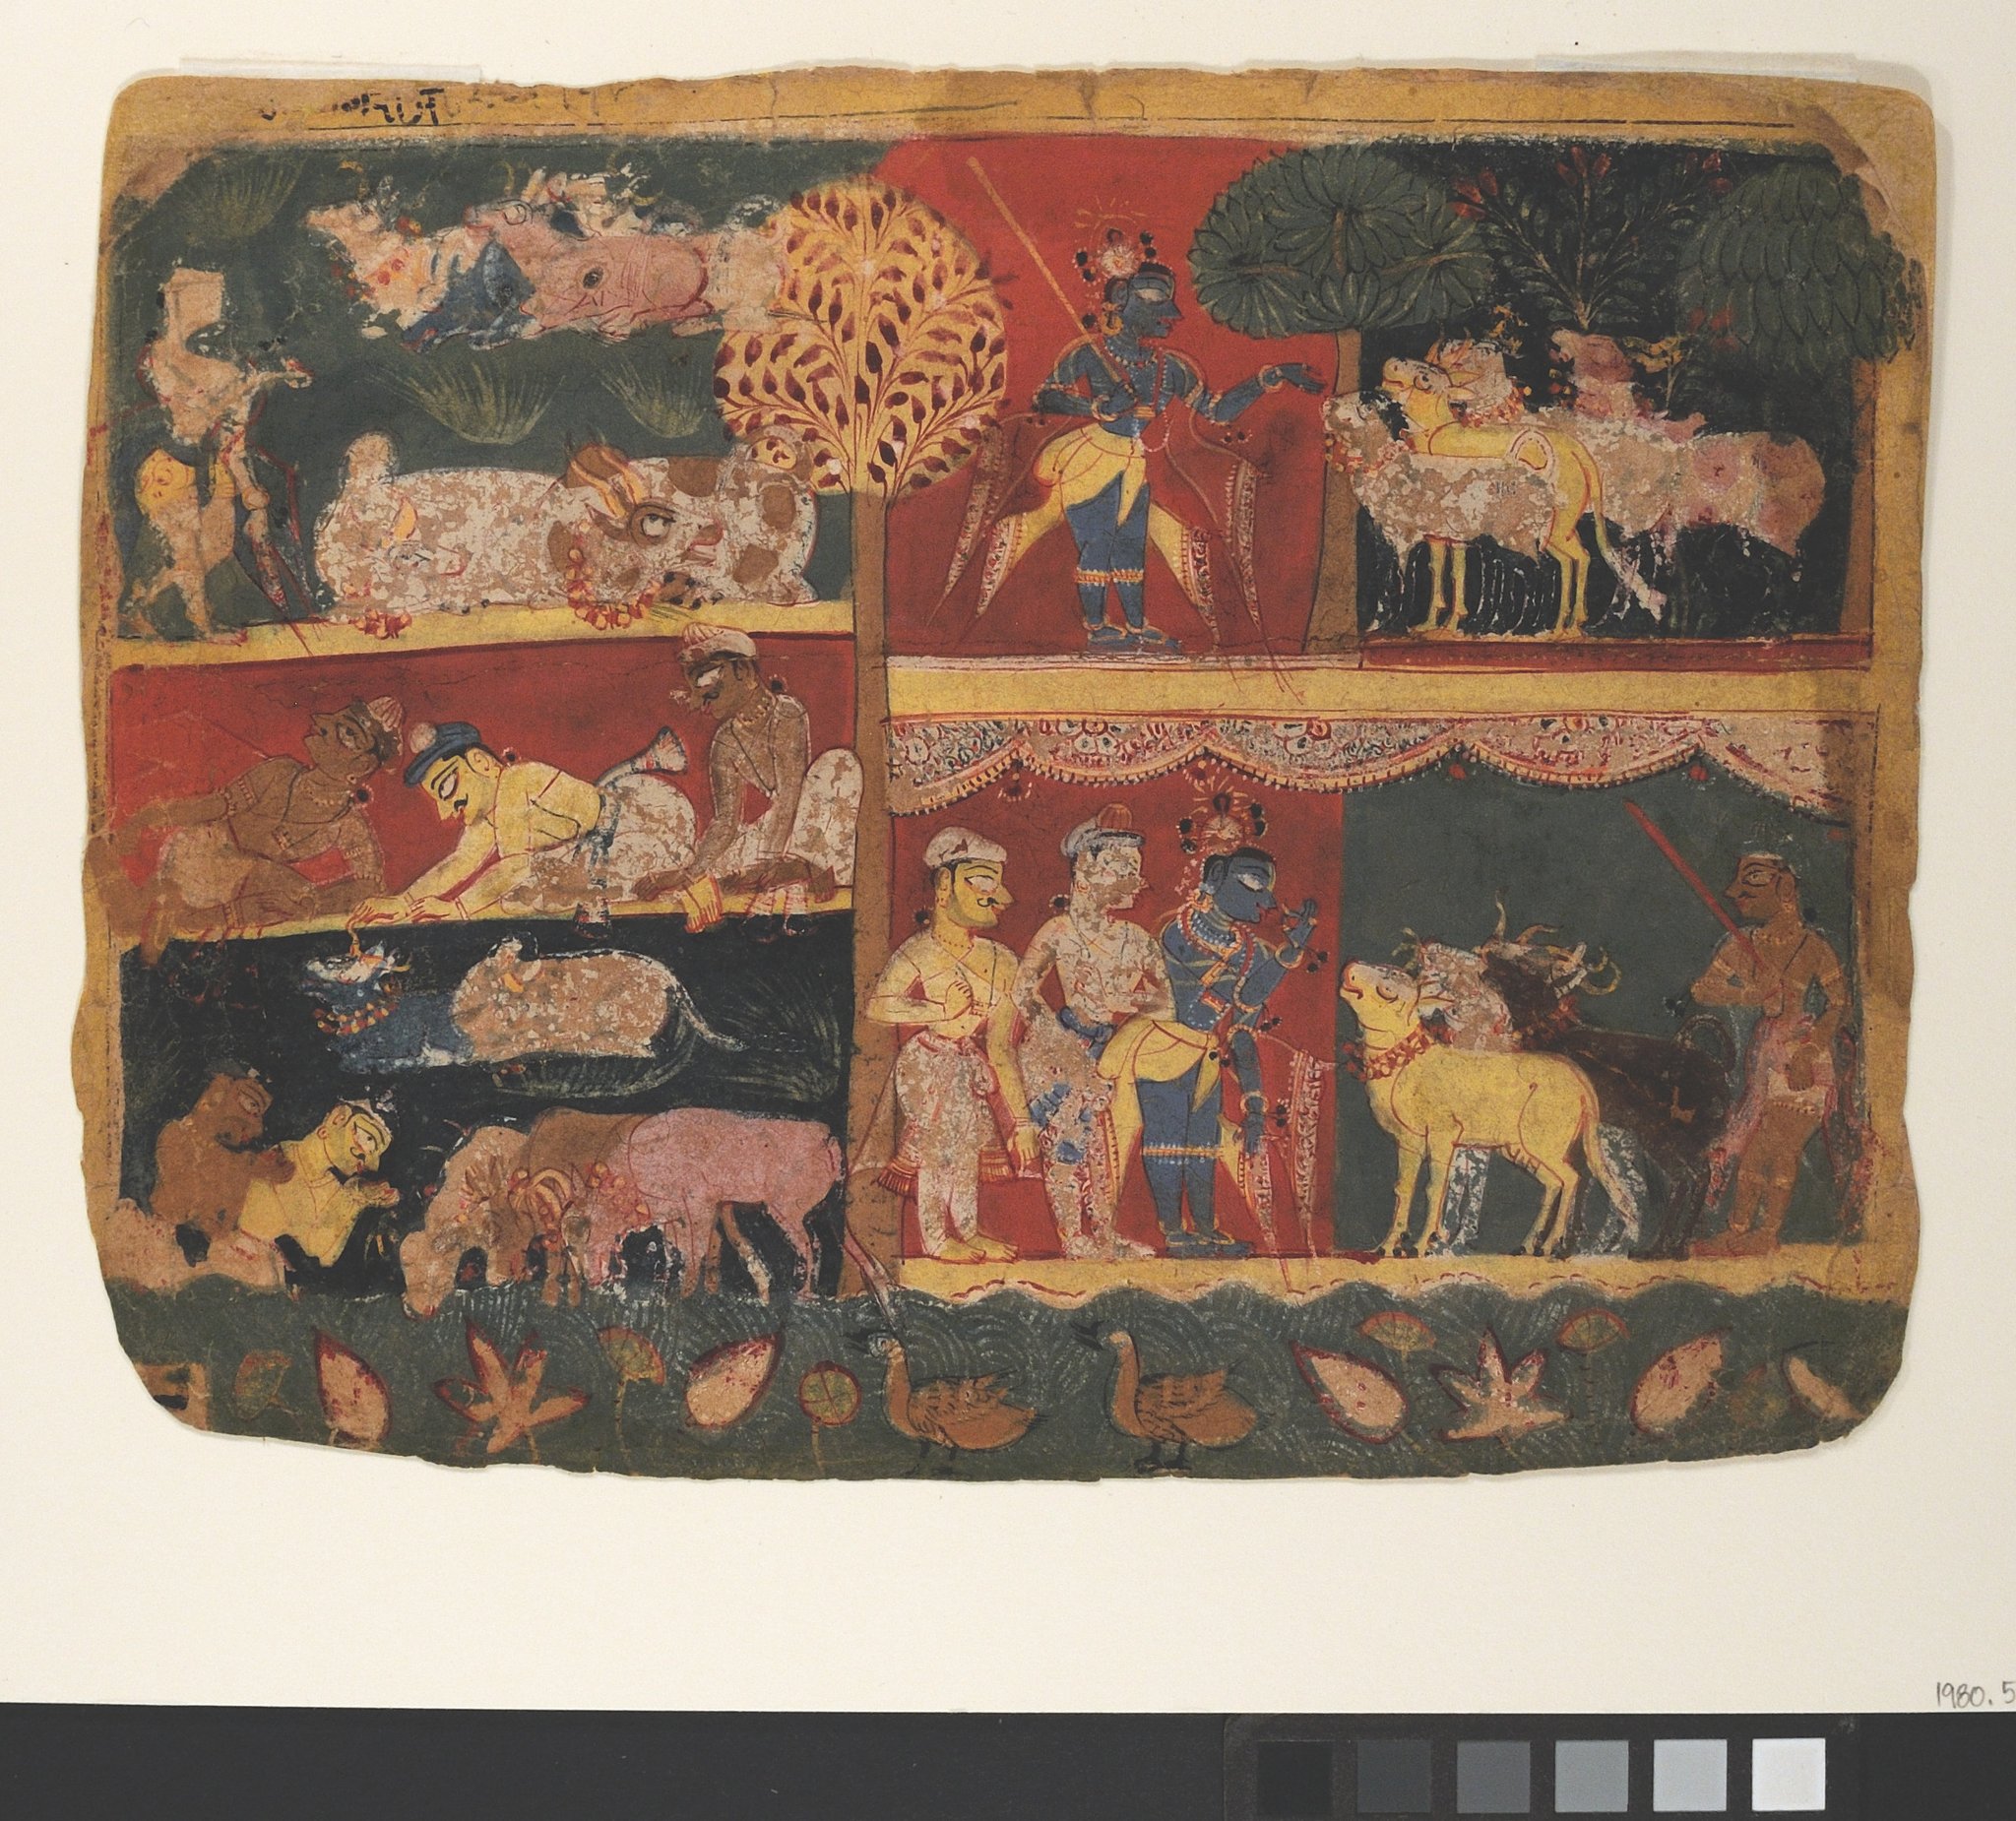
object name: folio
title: Krishna and the Cowherds: Page from a Dispersed Bhagavata Purana (Ancient Stories of Lord Vishnu)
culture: indian, delhi-agra area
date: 1520-1530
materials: ink, paper, watercolor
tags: men,cows,krishna